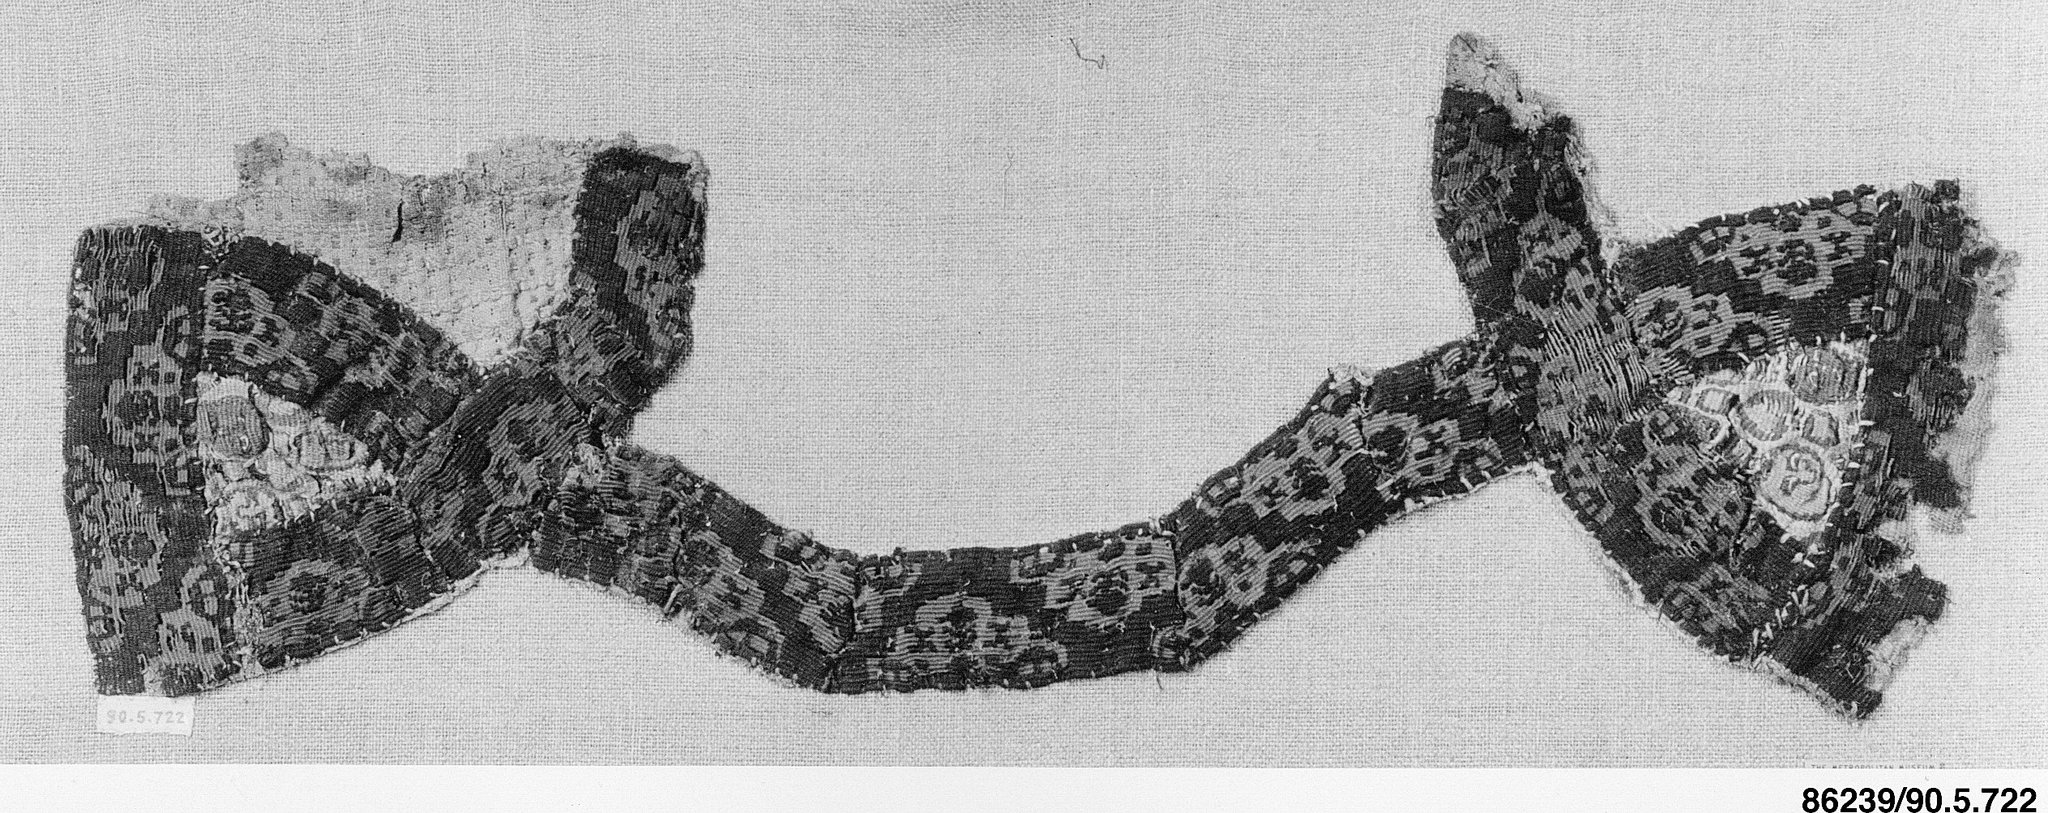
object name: textile fragment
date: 401-600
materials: linen, wool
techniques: weave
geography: egypt